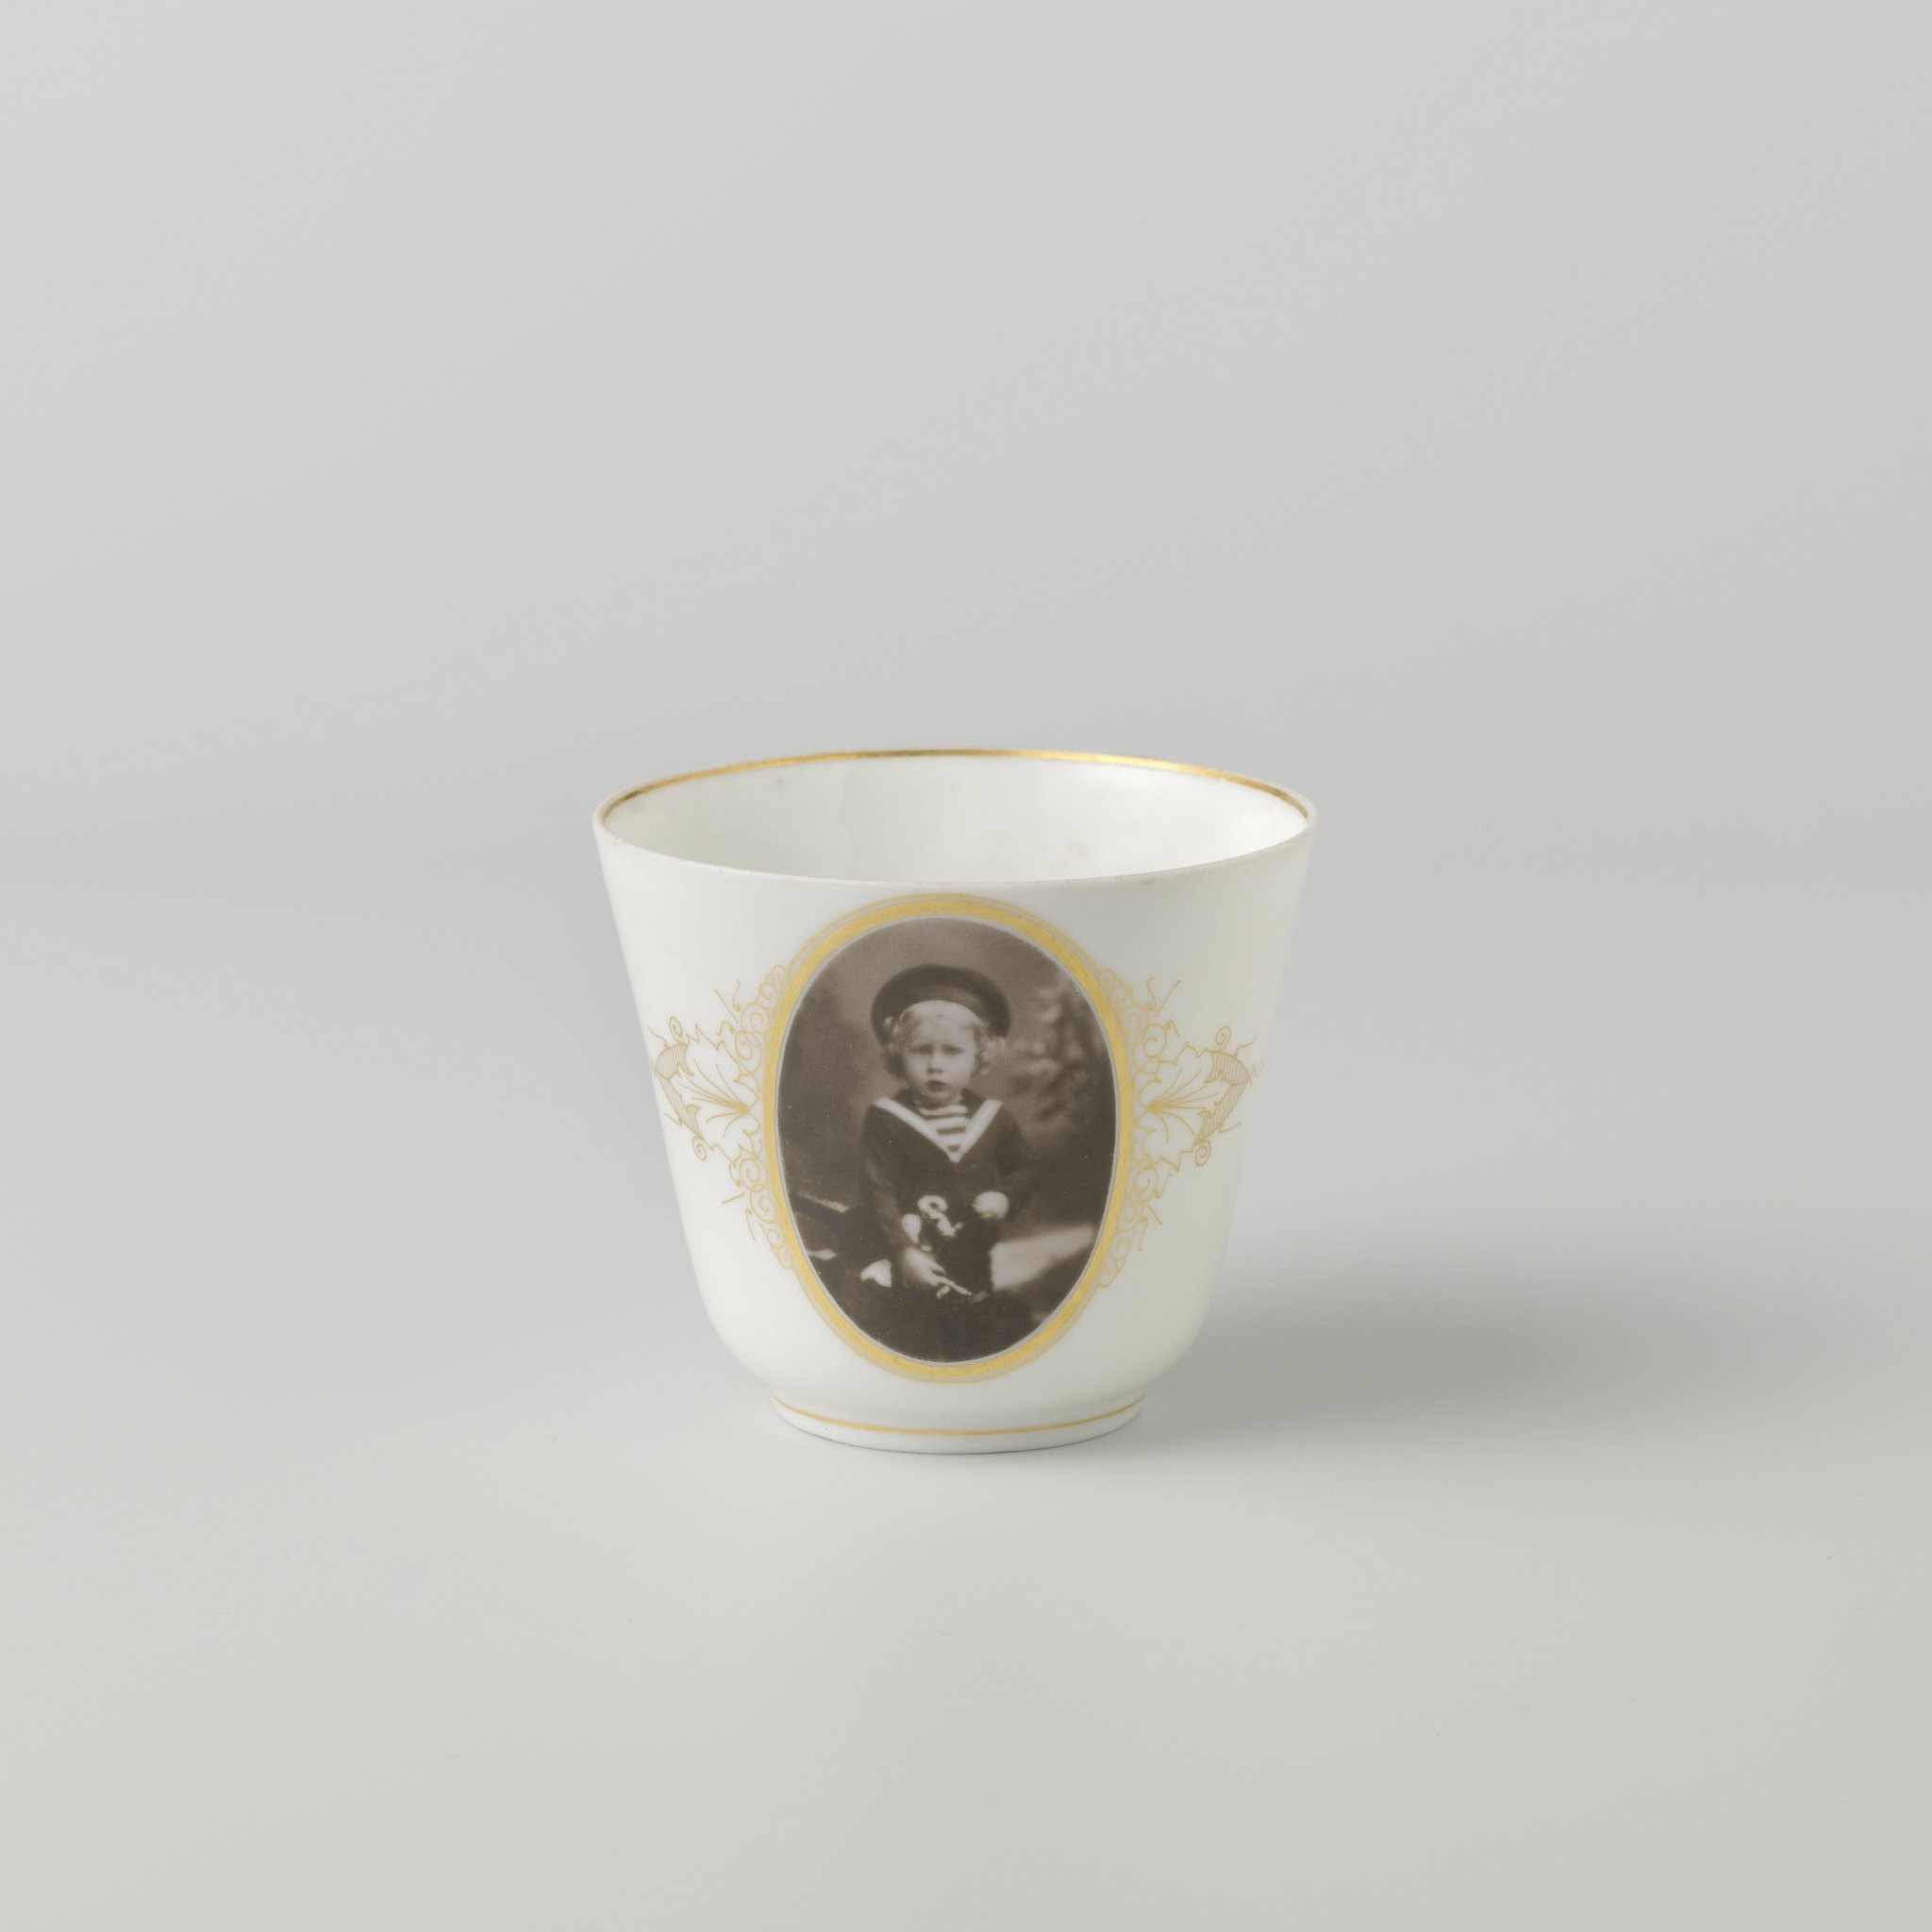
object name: kop en schotel, kop en schotel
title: Schotel (zonder afbeelding) en kop met portret van een kind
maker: Anonymous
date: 1850-1949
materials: ceramic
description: Schotel (zonder afbeelding) en kop met portret van een kind